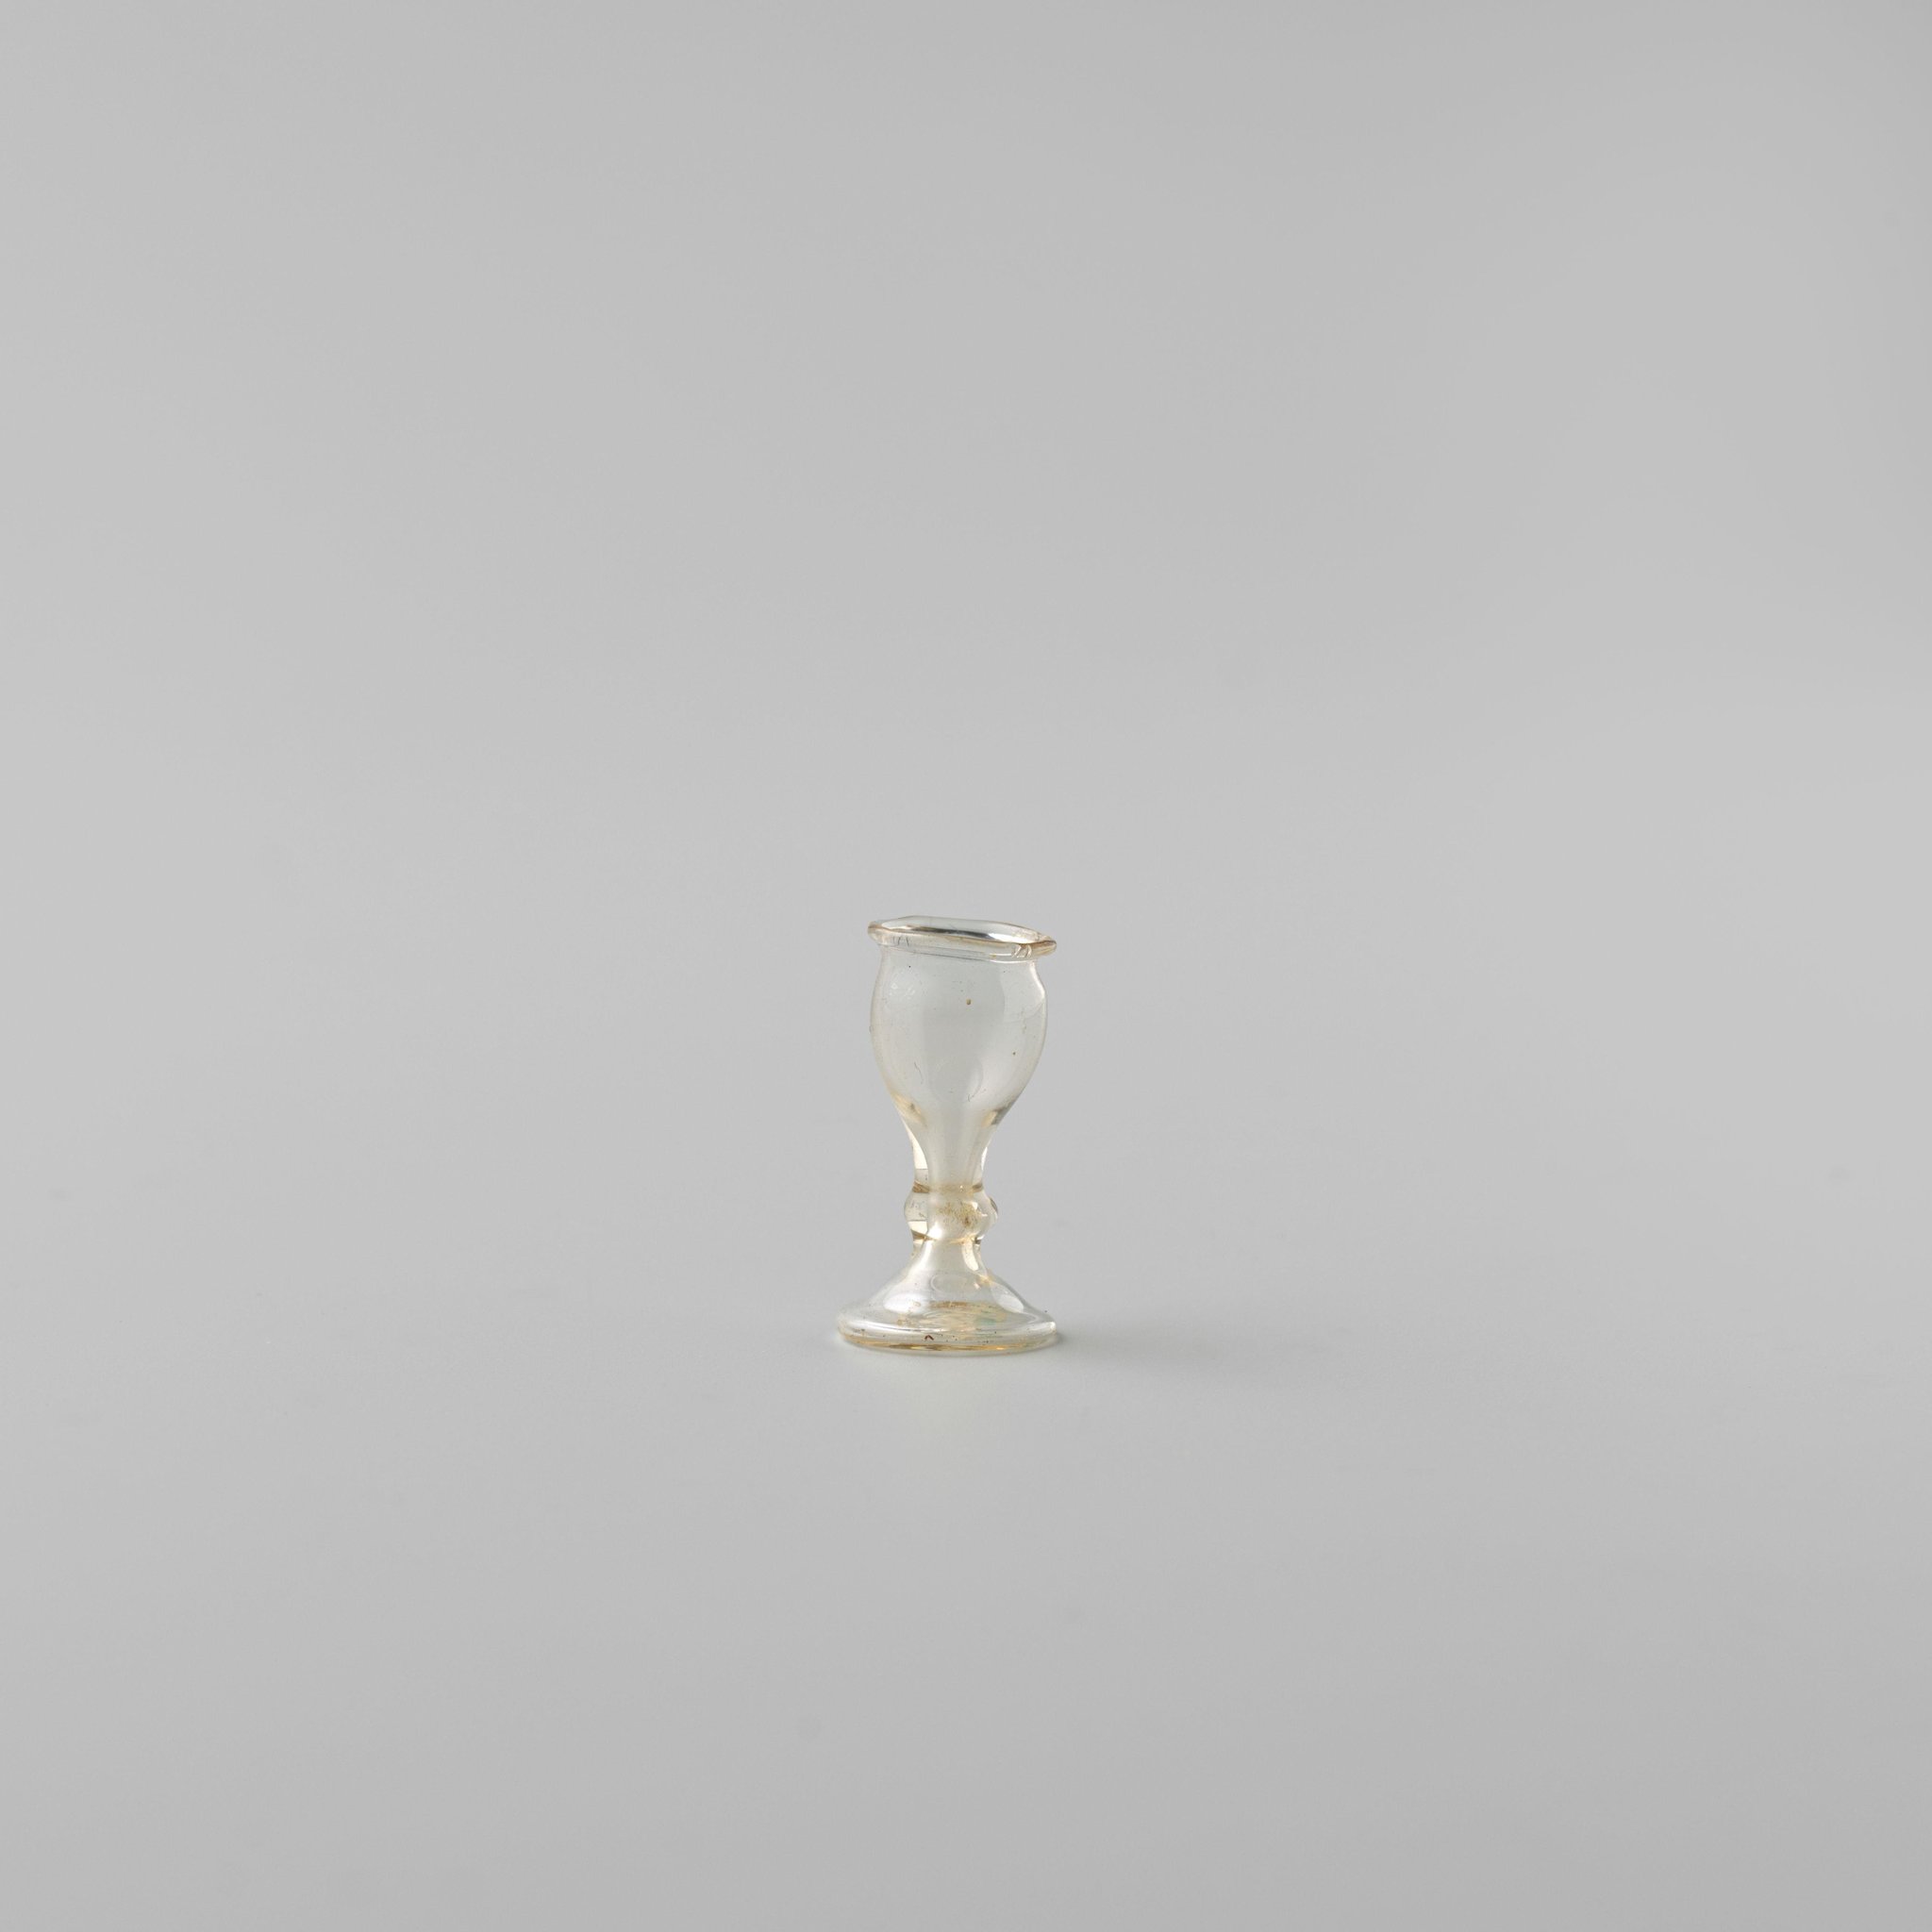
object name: miniature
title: Kelkglas, met kelk doorlopend in stam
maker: Anonymous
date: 1800-1849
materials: glass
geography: bristol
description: Kelkglas van helder, kleurloos glas, kelk met uitstaande mondrand, doorlopend in stam met verdikking en voet.